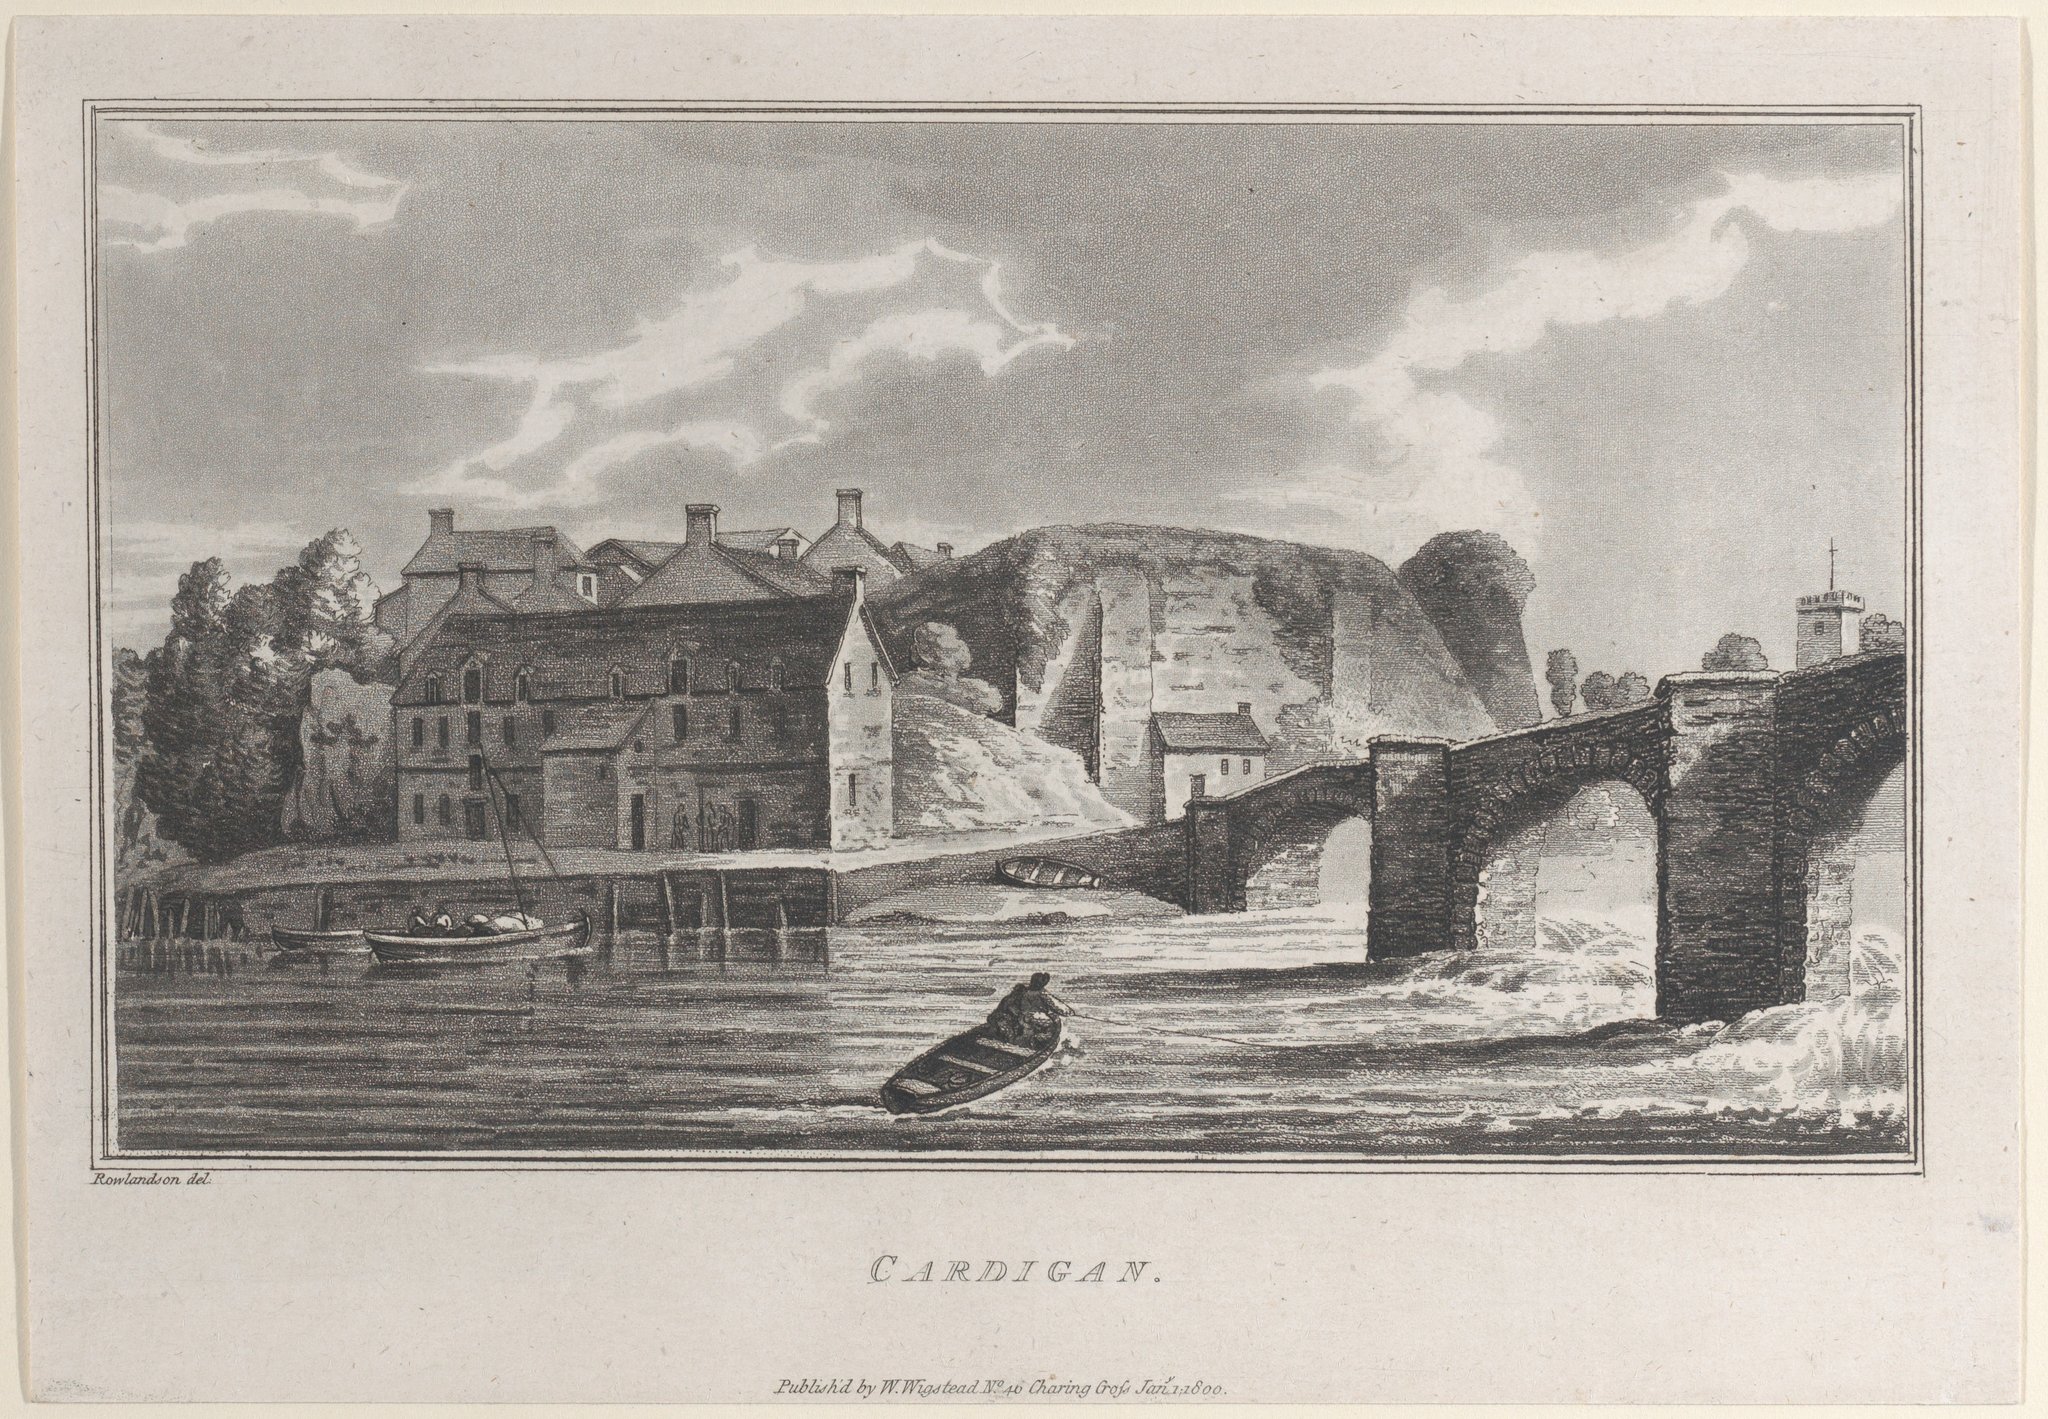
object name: print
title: Cardigan, from "Remarks on a Tour to North and South Wales, in the year 1797"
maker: john hill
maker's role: artist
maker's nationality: british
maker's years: 1714-1775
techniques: aquatint, etching